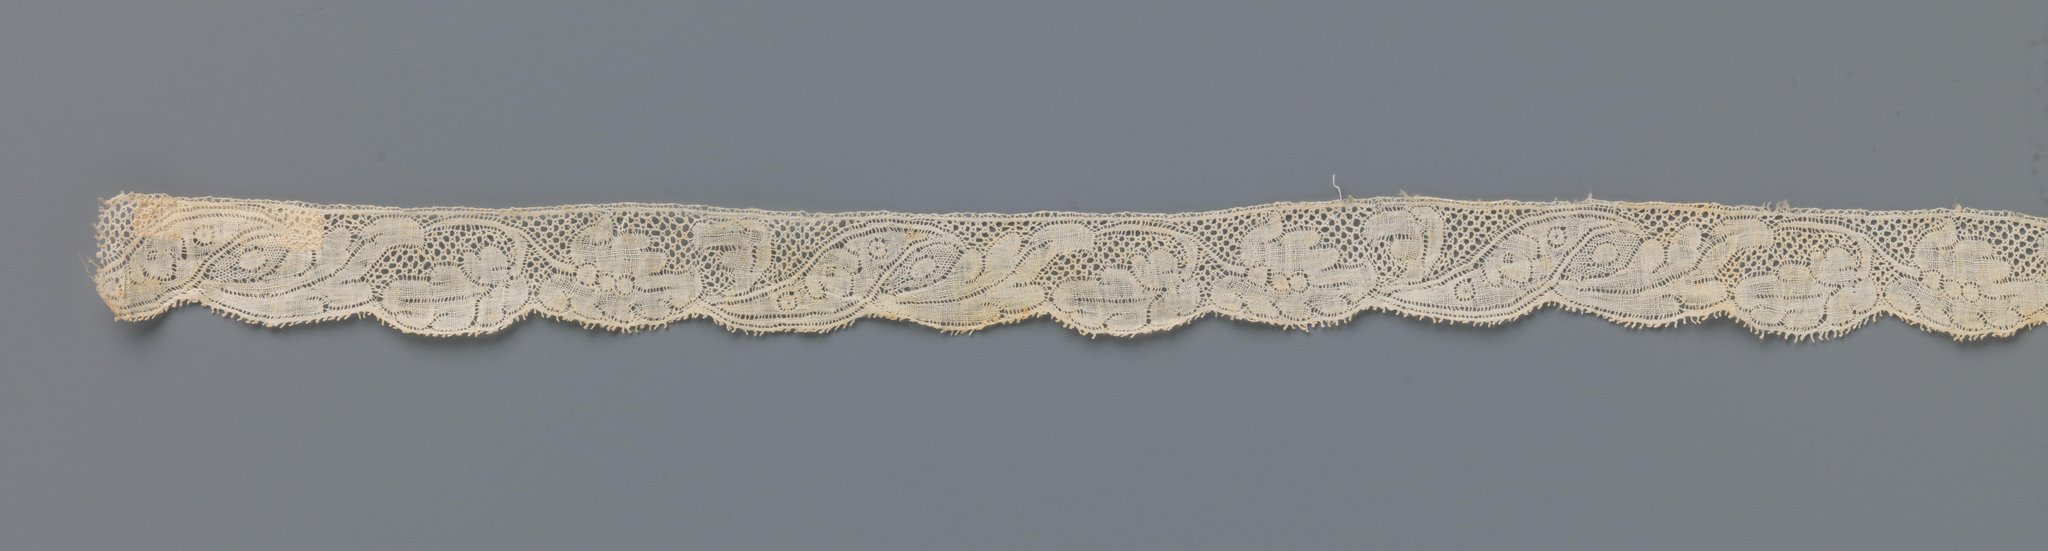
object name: strip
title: Strook kloskant met pluimvormige bloem aan gebogen steel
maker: Anonymous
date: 1700-1799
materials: linen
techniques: lace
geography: flanders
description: Strook naturelkleurige kloskant, oudvlaamse kant. Het zich herhalende patroon bestaat uit een aaneenschakeling van gebogen stelen met twee pluimvormige bloemen, die zich aan het eind van de steel in tegengestelde richting afsplitsen. De motieven zijn met elkaar verbonden door een traliegrond, een vijfgaatjesgrond. De motieven zijn gemaakt in linnenslag met opengewerkte randjes en een spitsovaalvormig motiefje is gemaakt in netslag. De bovenzijde is recht afgewerkt. De flauw geschulpte onderzijde komt voort uit het patroon en is afgewerkt met picots.